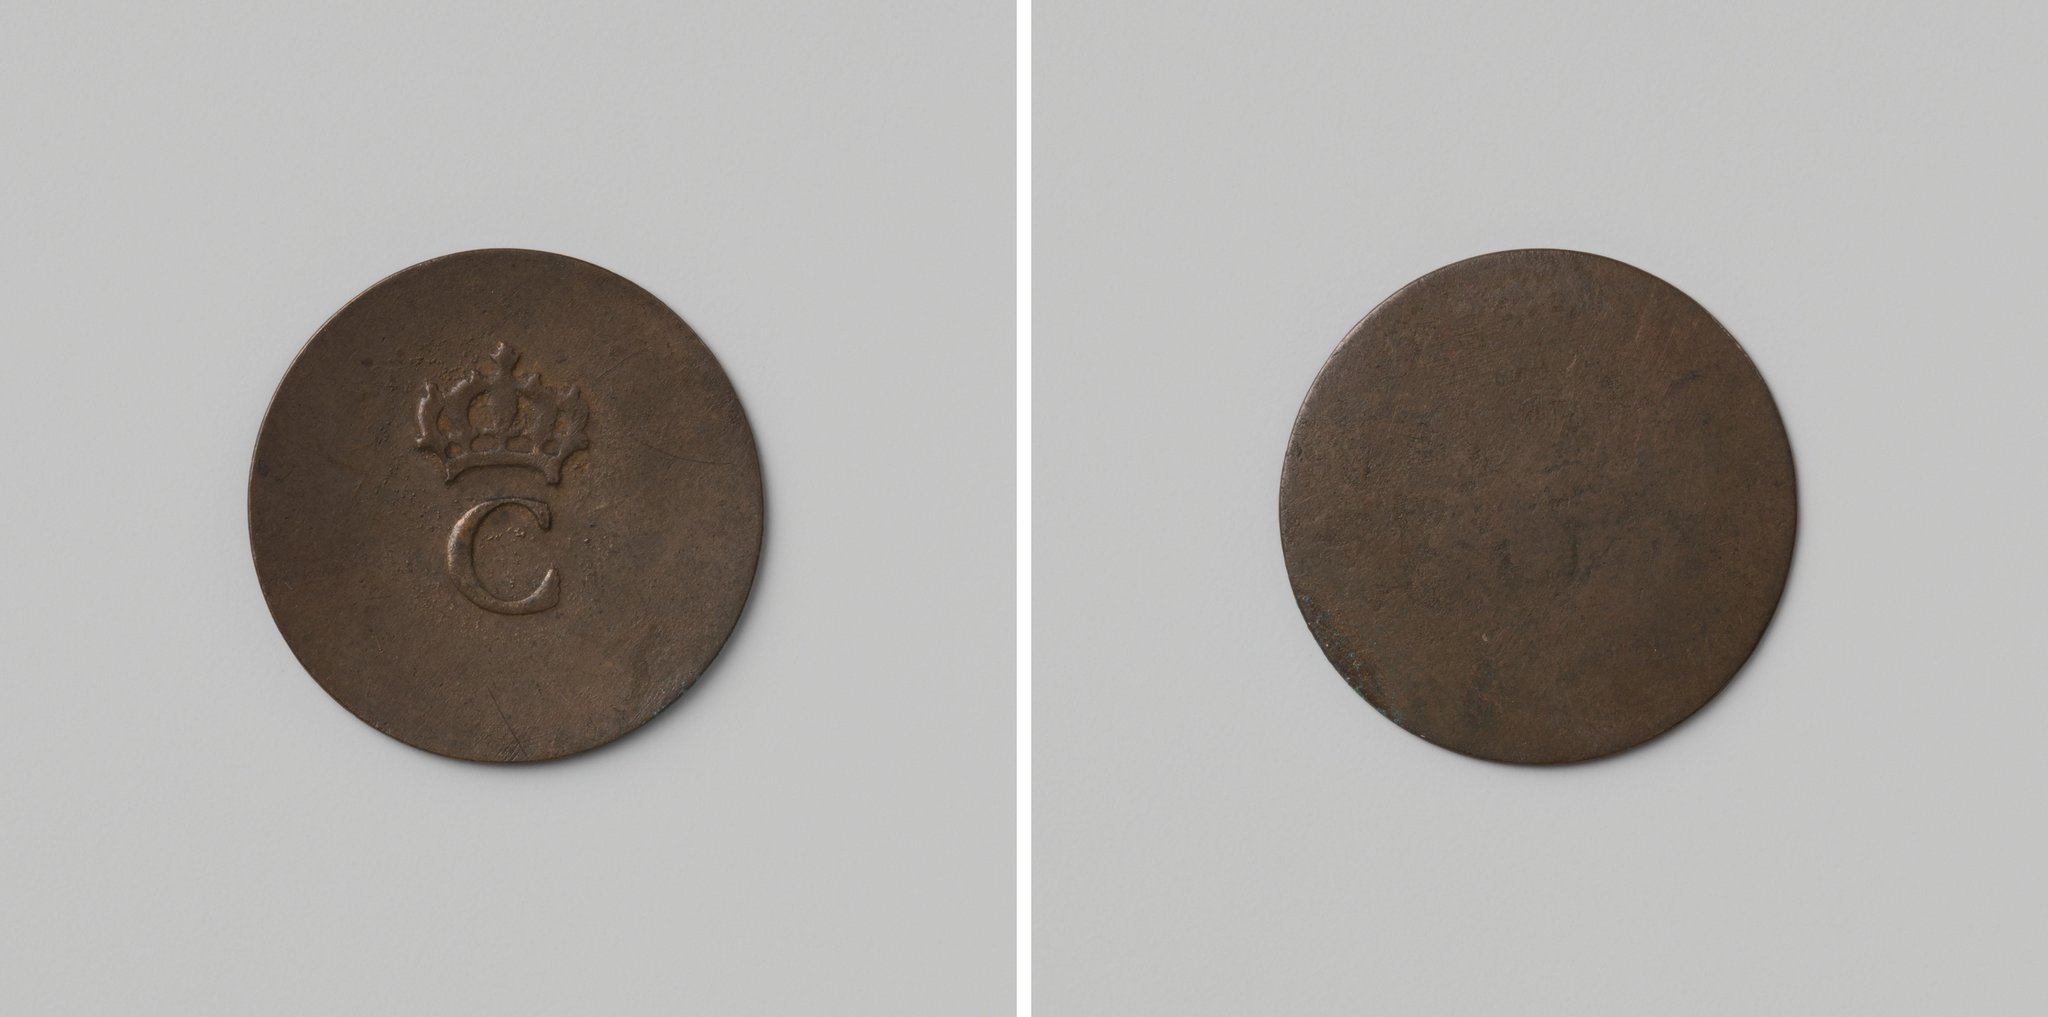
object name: medal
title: Penning met gekroonde letter C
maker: Anonymous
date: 1650-1850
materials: brass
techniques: striking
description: Eenzijdige messing penning. Voorzijde: gekroonde letter C. Keerzijde: blanco